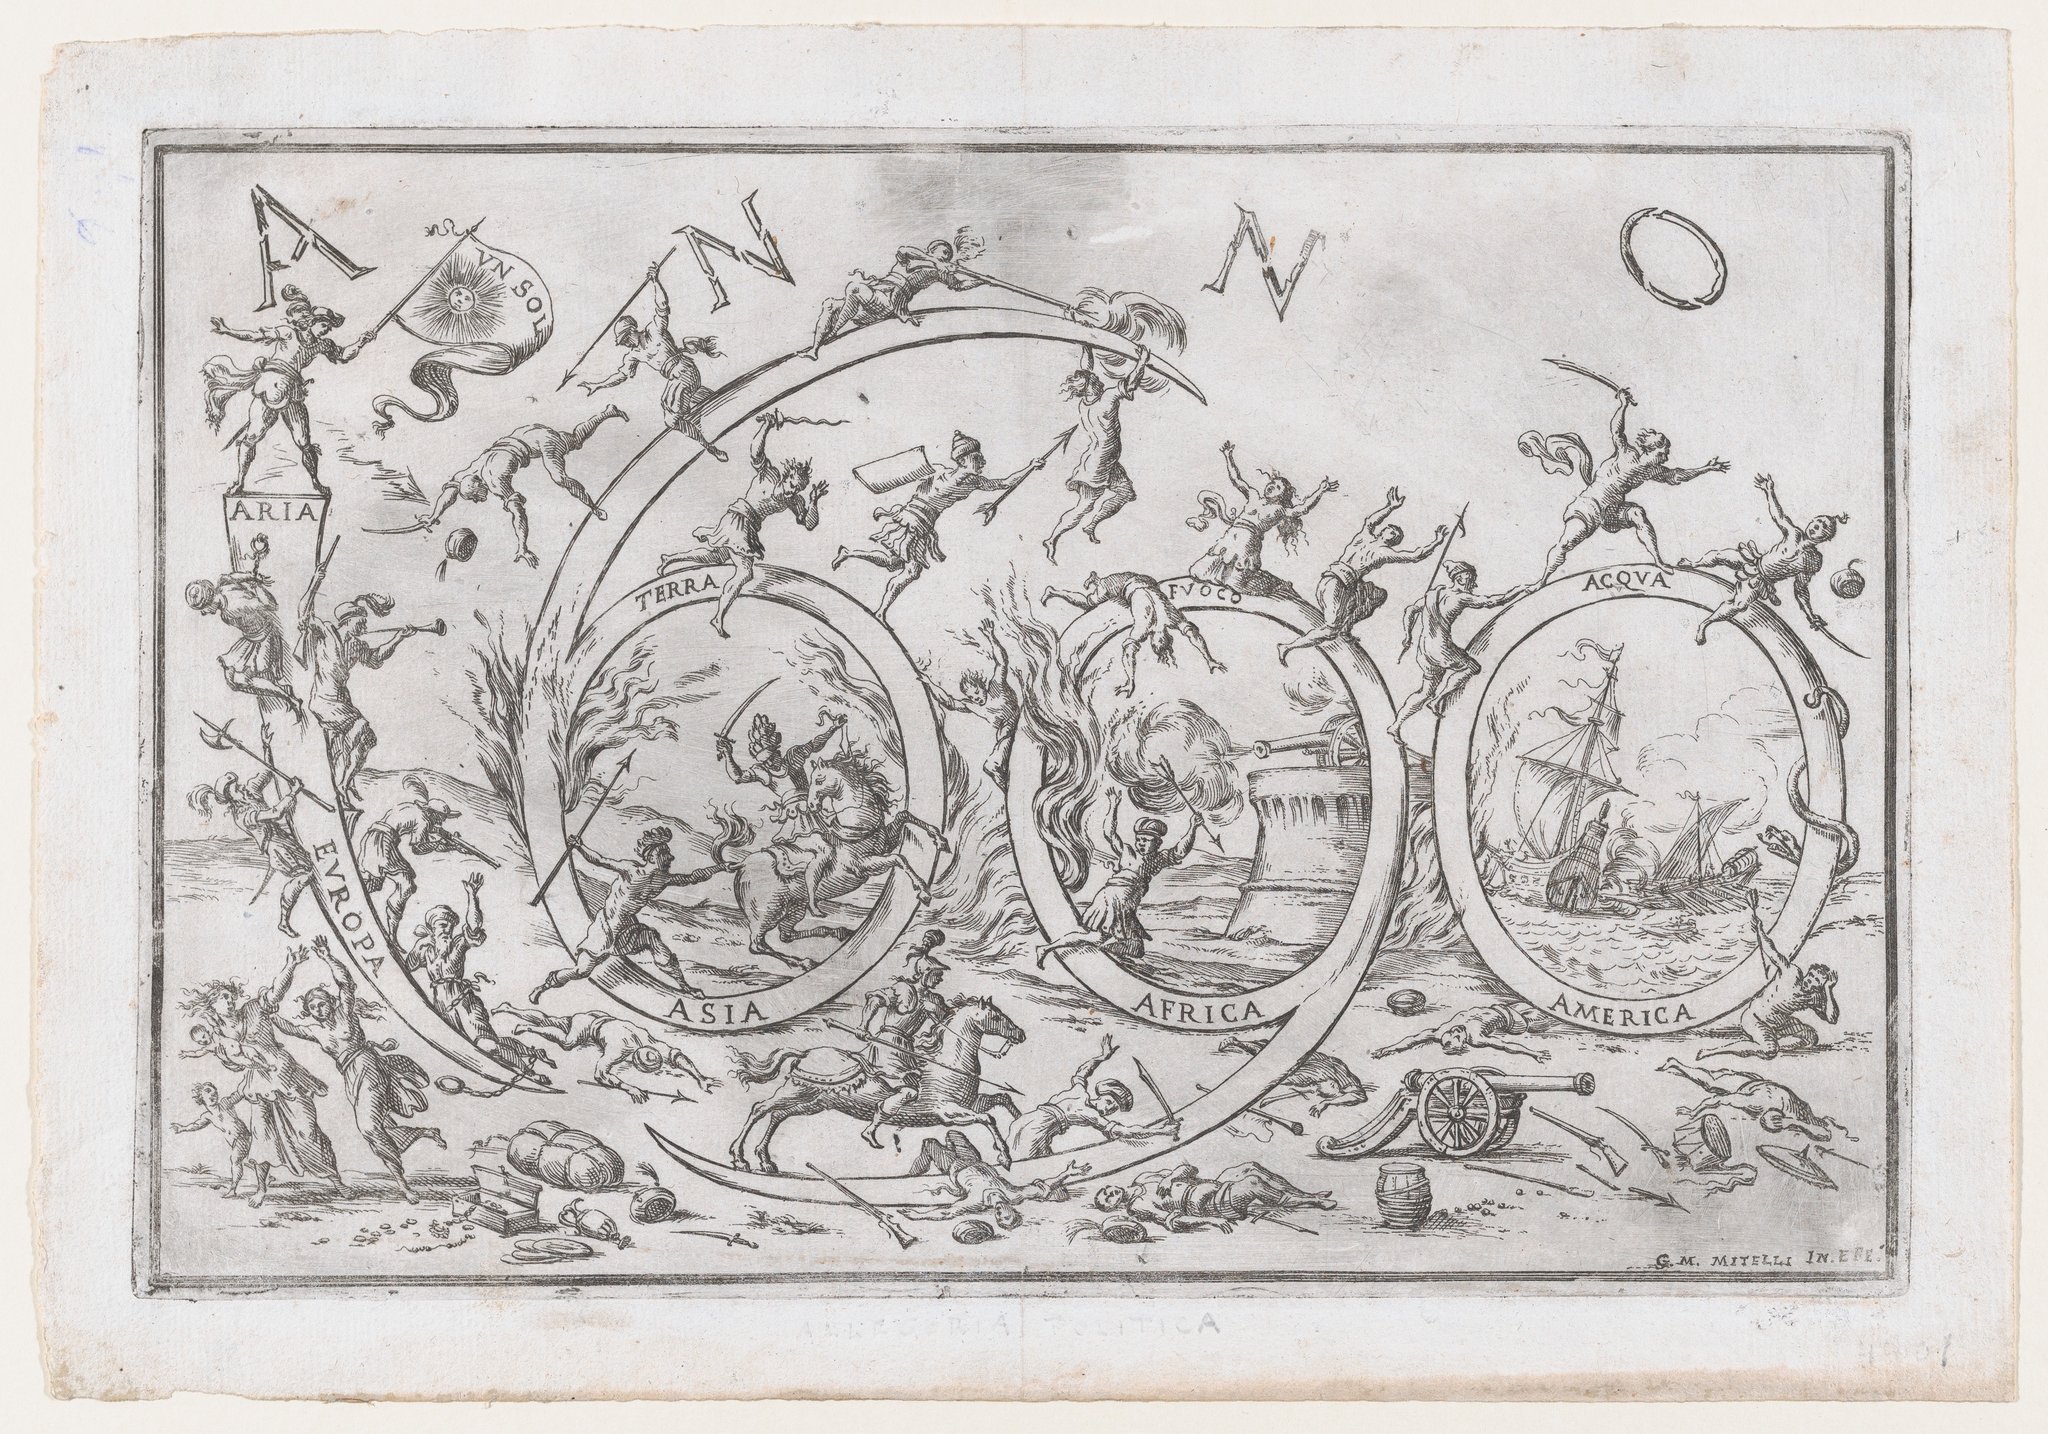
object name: print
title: 'Anno 1690' (the Year 1690), with numerous warring figures clambering on and hanging from the numbers, allusions to the Allegories of the Four Elements and the Four Continents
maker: giuseppe maria mitelli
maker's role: artist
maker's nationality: italian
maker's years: 1634-1718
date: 1690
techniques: etching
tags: battles,cannons,men,horses,flags